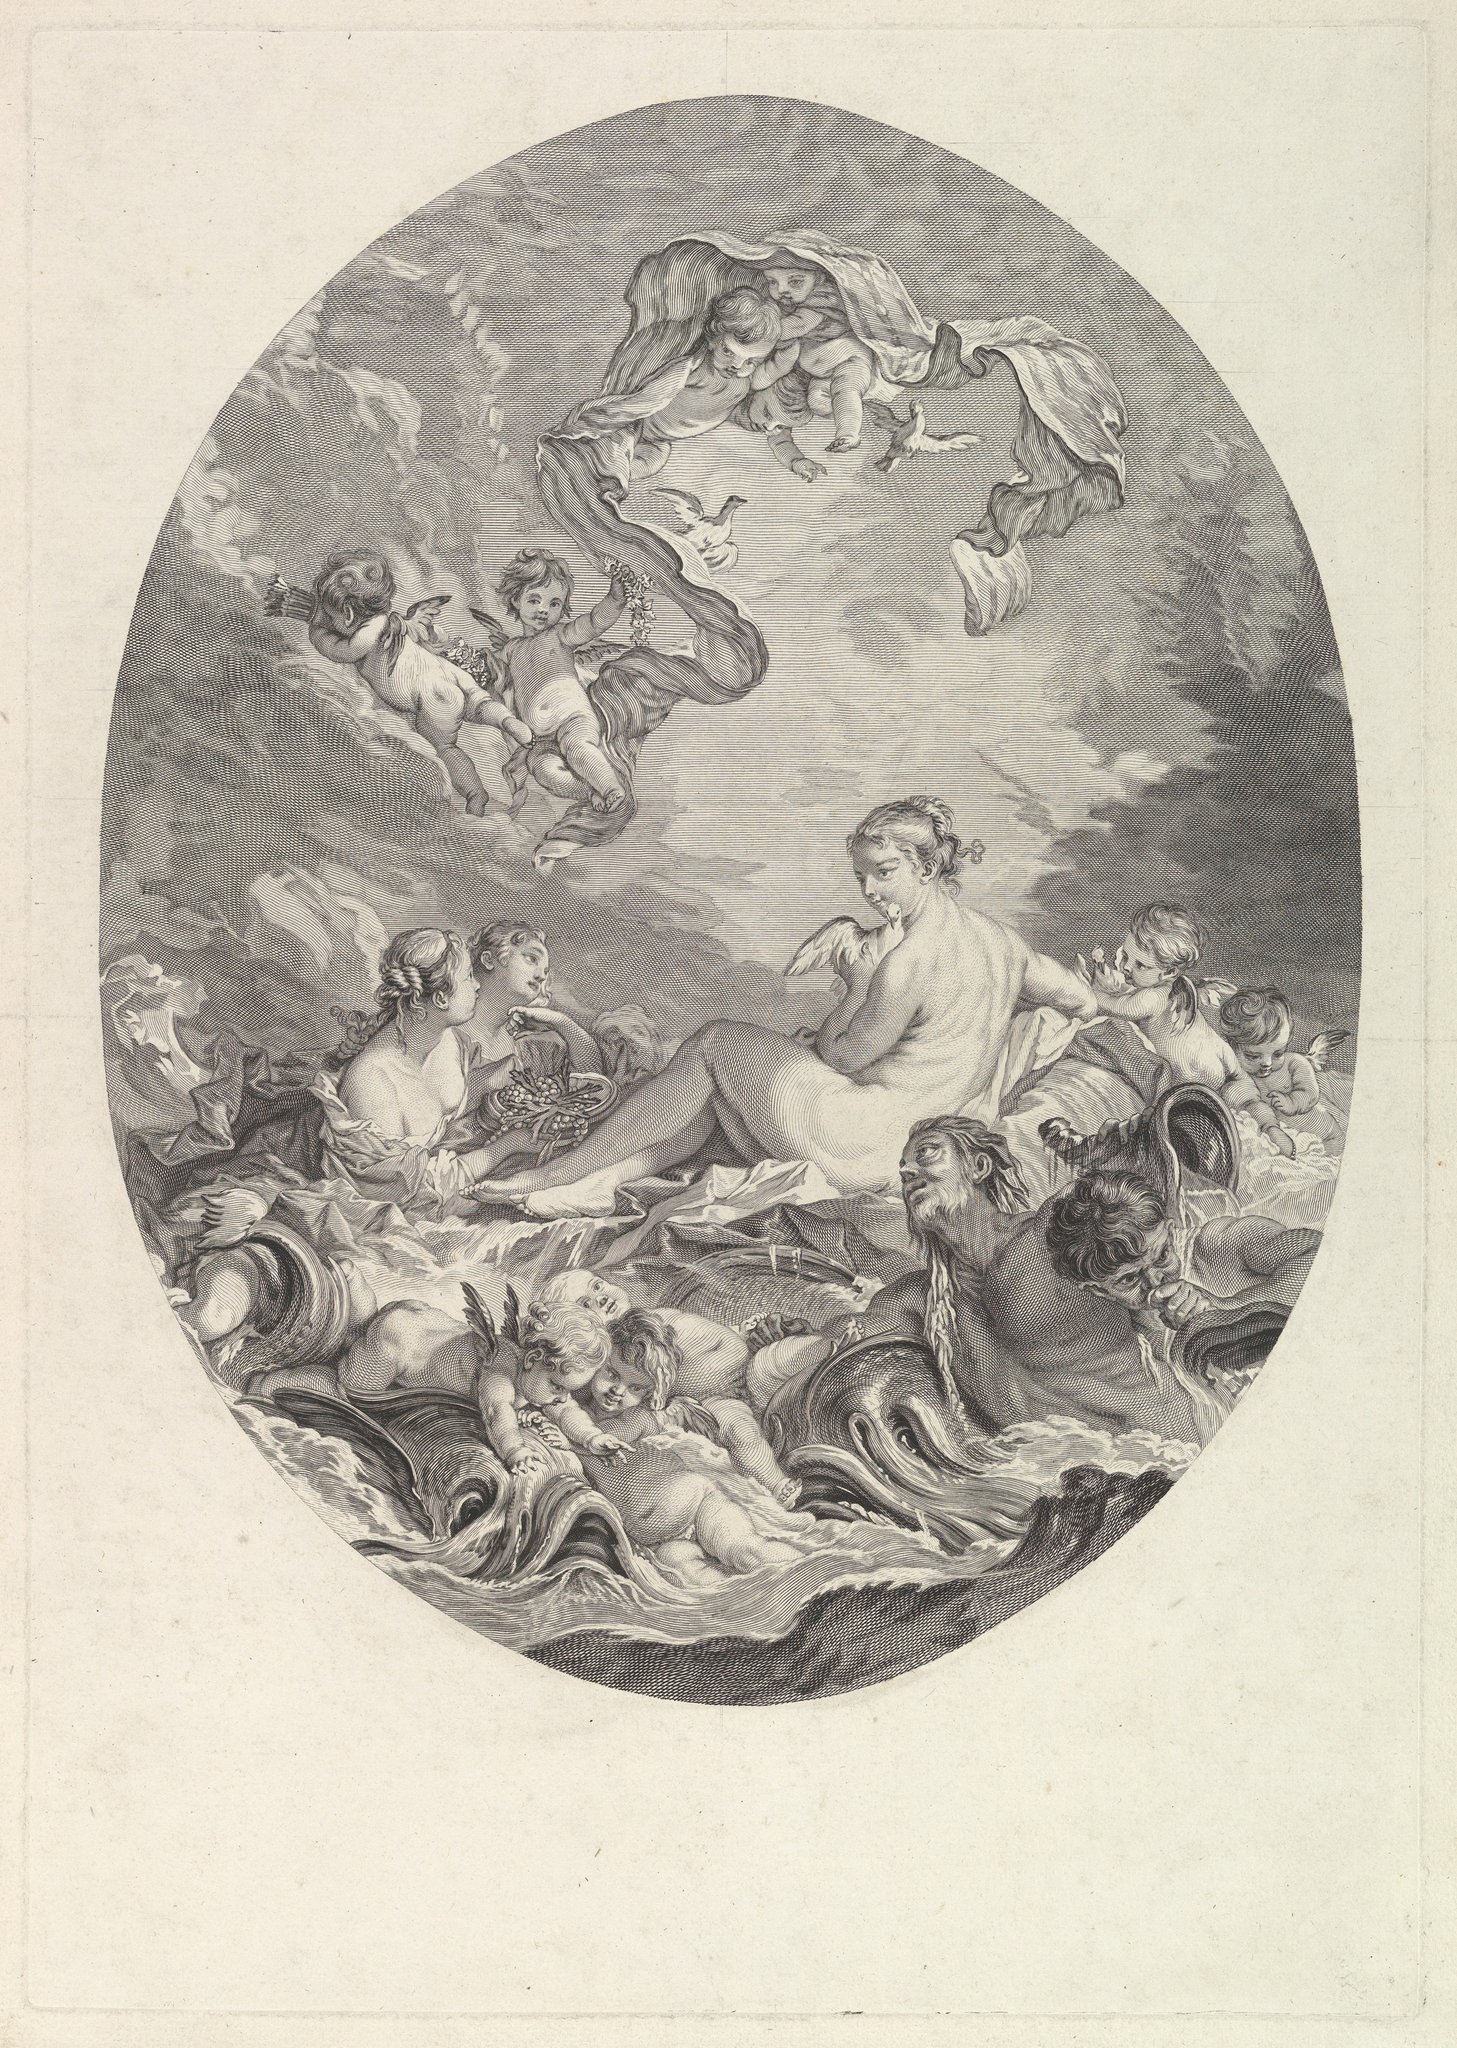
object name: print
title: Naissance et Triomphe de Venus (The Birth and Triumph of Venus)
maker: jean daullé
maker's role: artist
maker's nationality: french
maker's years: 1703-1763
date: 1701-1800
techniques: engraving, etching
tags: doves,nymphs,putti,venus